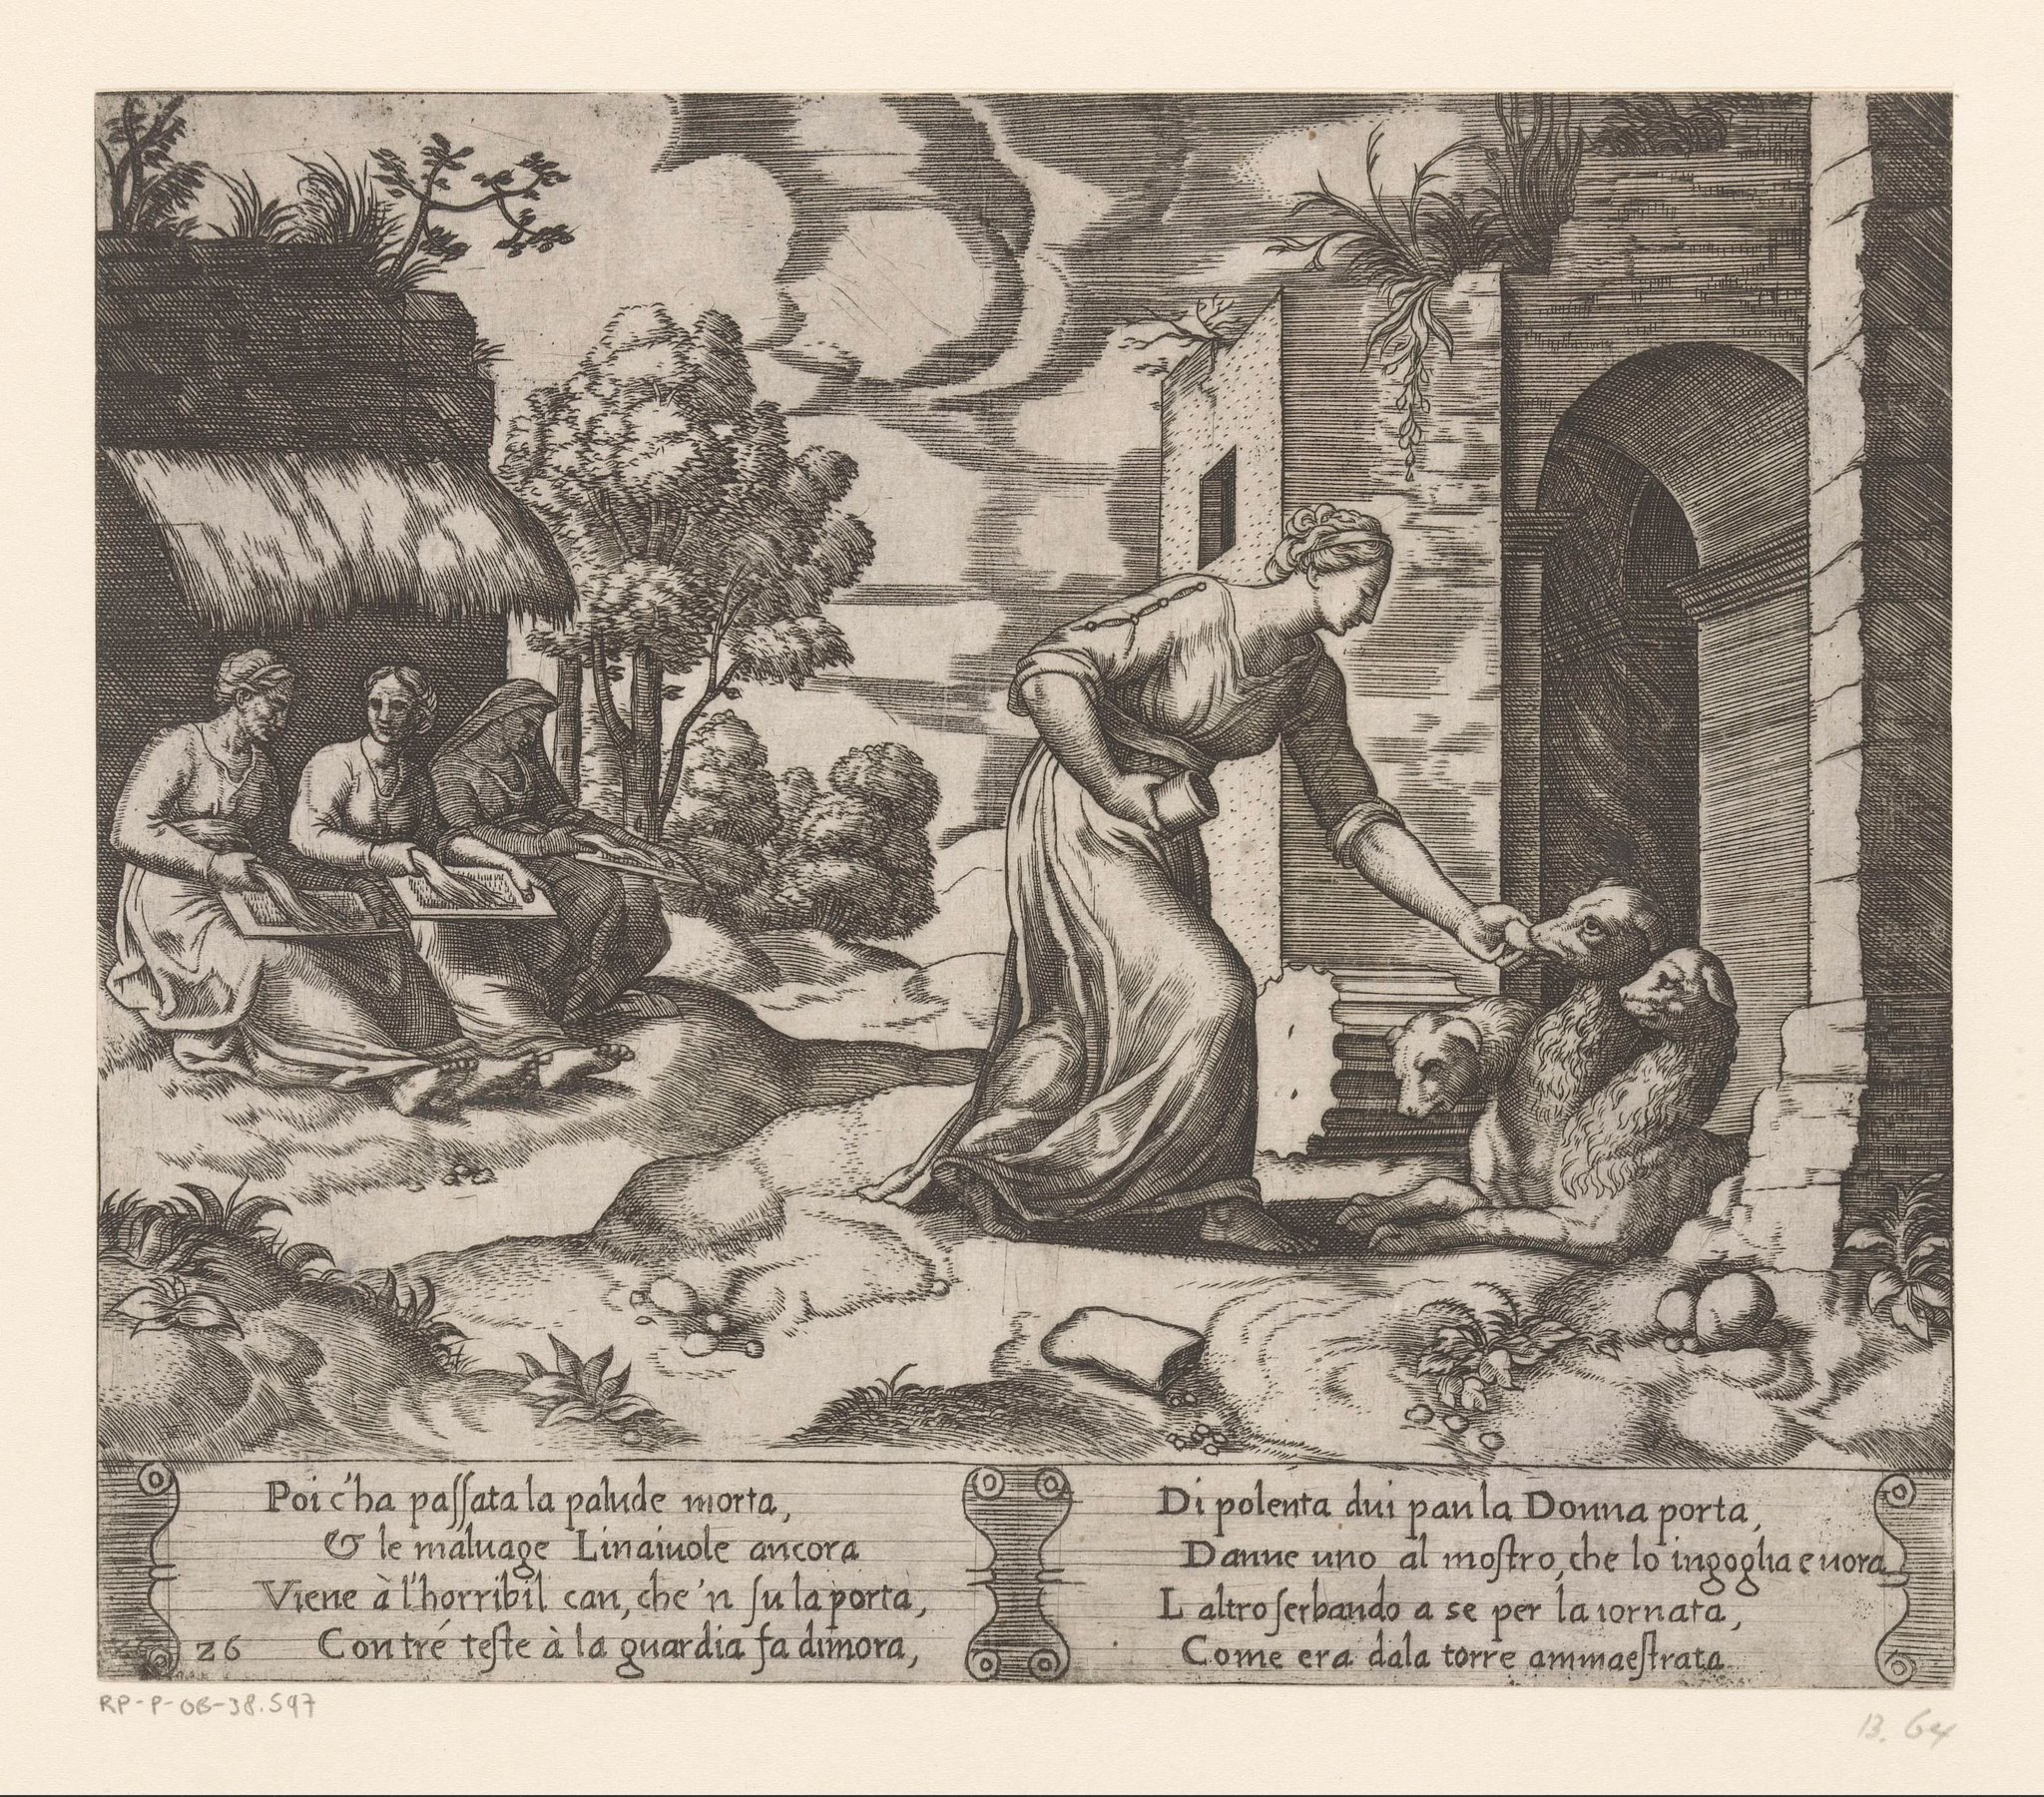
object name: print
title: Psyche voert Cerberus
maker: meester van de dobbelsteen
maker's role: print maker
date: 1530-1560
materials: paper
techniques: engraving, intaglio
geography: italy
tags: psyche feeds cerberus with a cake, fates, parcae (moirae)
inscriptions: collector's mark: Lugt 2228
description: Psyche voert Cerberus, de driekoppige hond die de ingang van de onderwereld bewaakt. Links de drie schikgodinnen, die de levensdraden van mensen spinnen. Italiaanse tekst in twee cartouches in ondermarge. Tweemaal genummerd linksonder: 26.